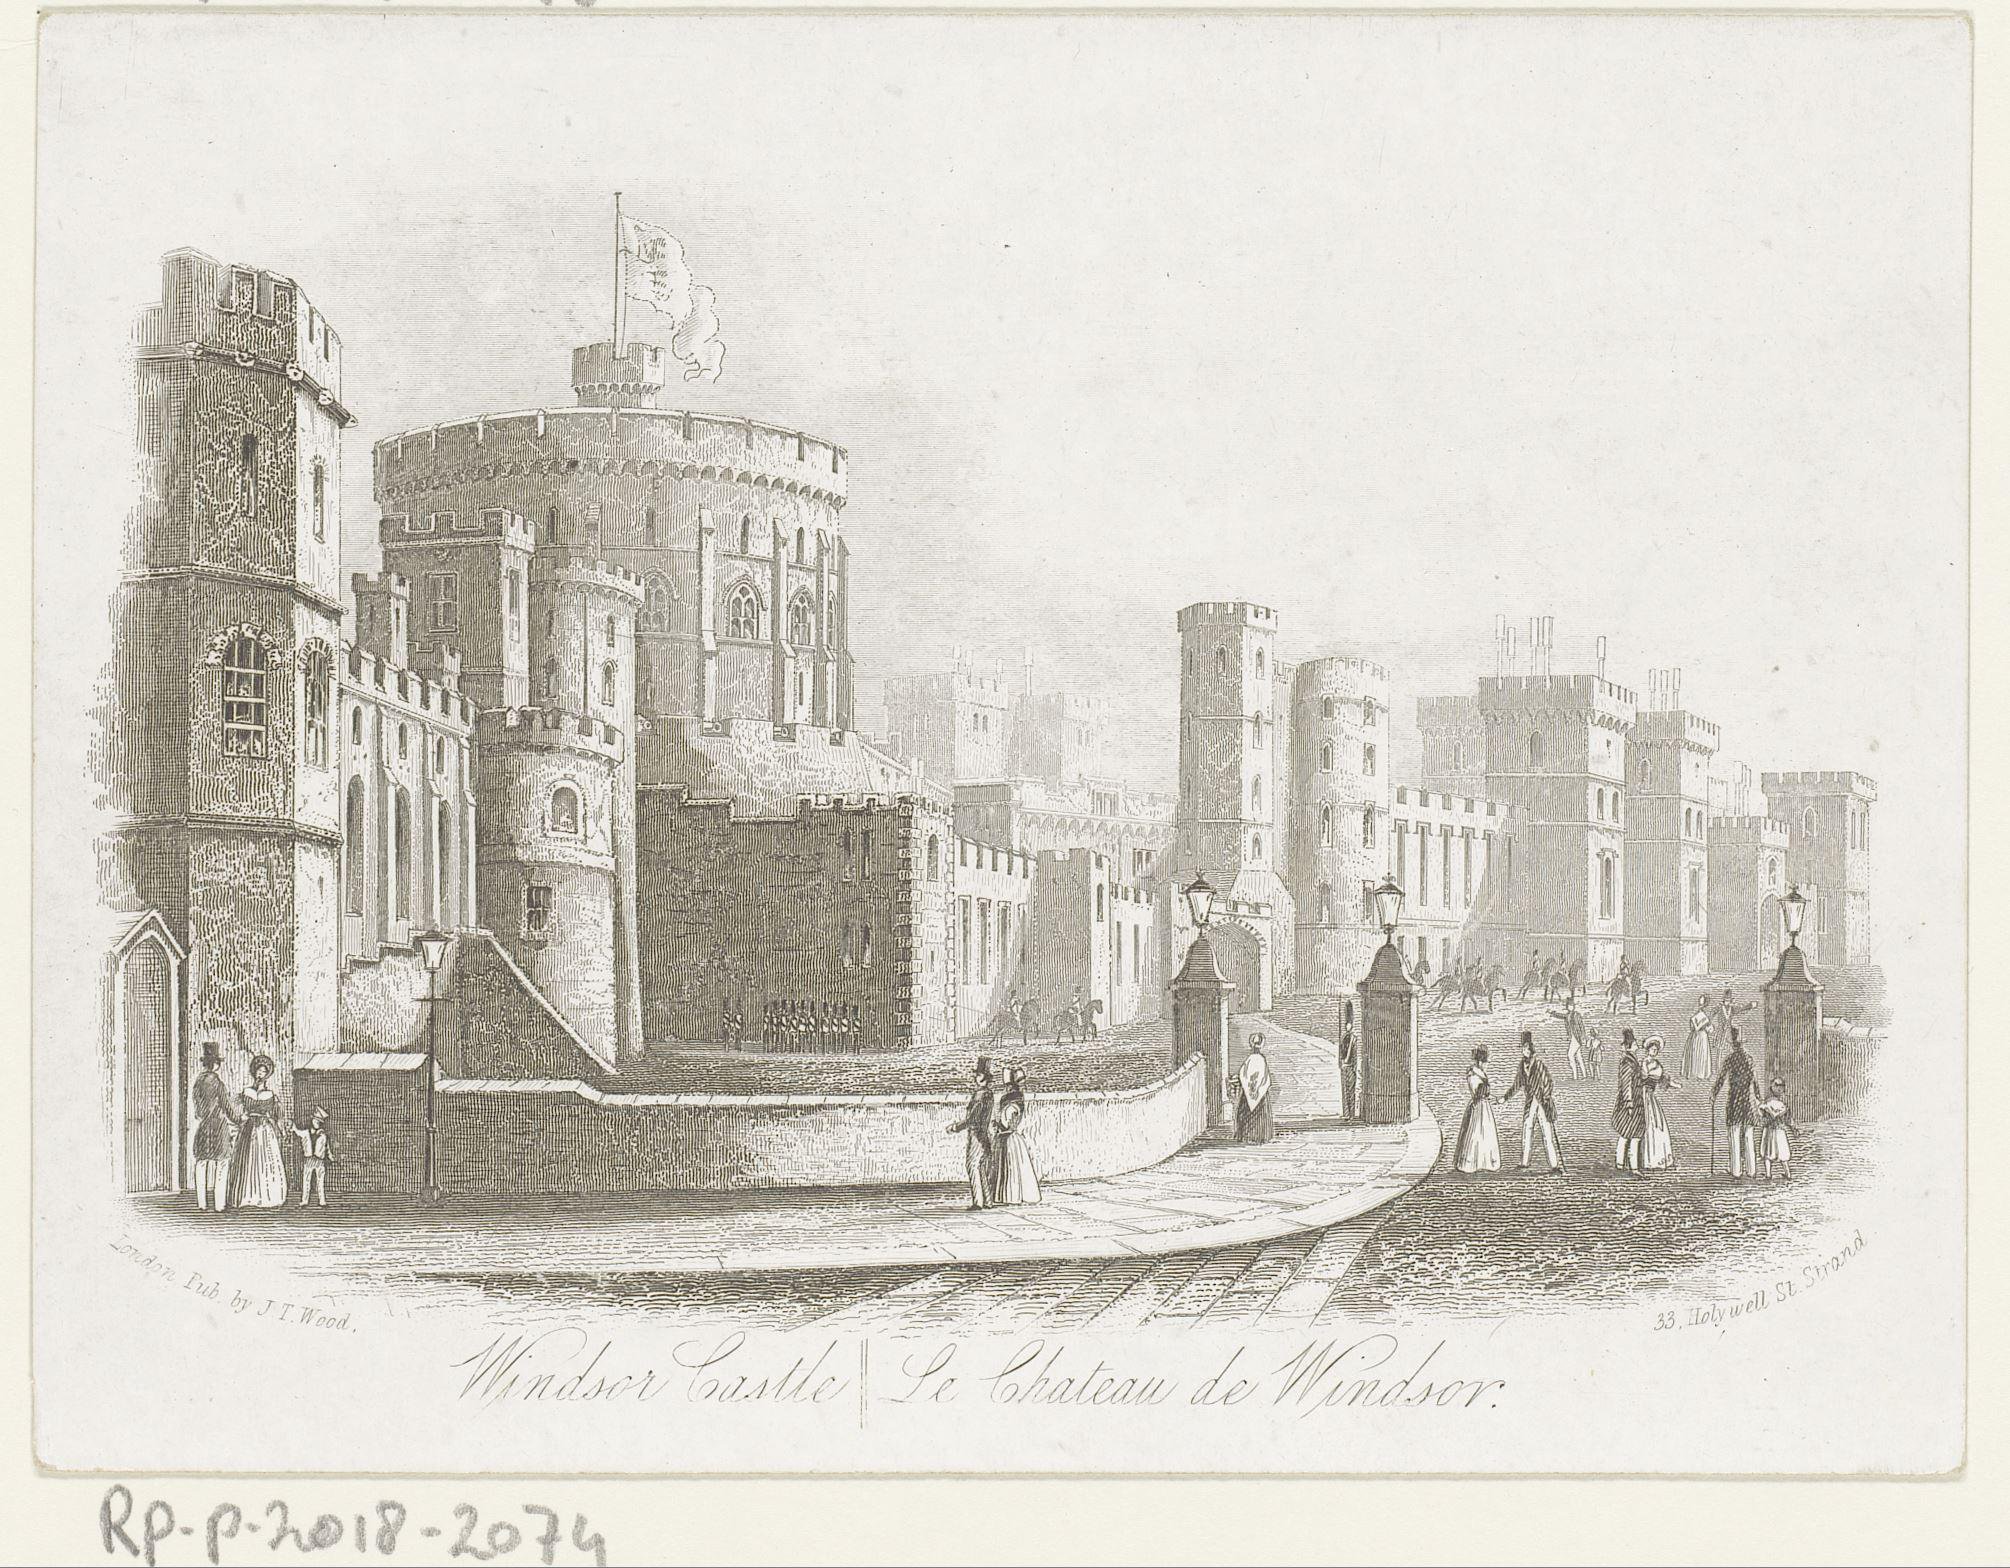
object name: print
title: Windsor Castle / Le Chateau de Windsor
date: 1841-1885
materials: paper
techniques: etching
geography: london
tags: castle, palace